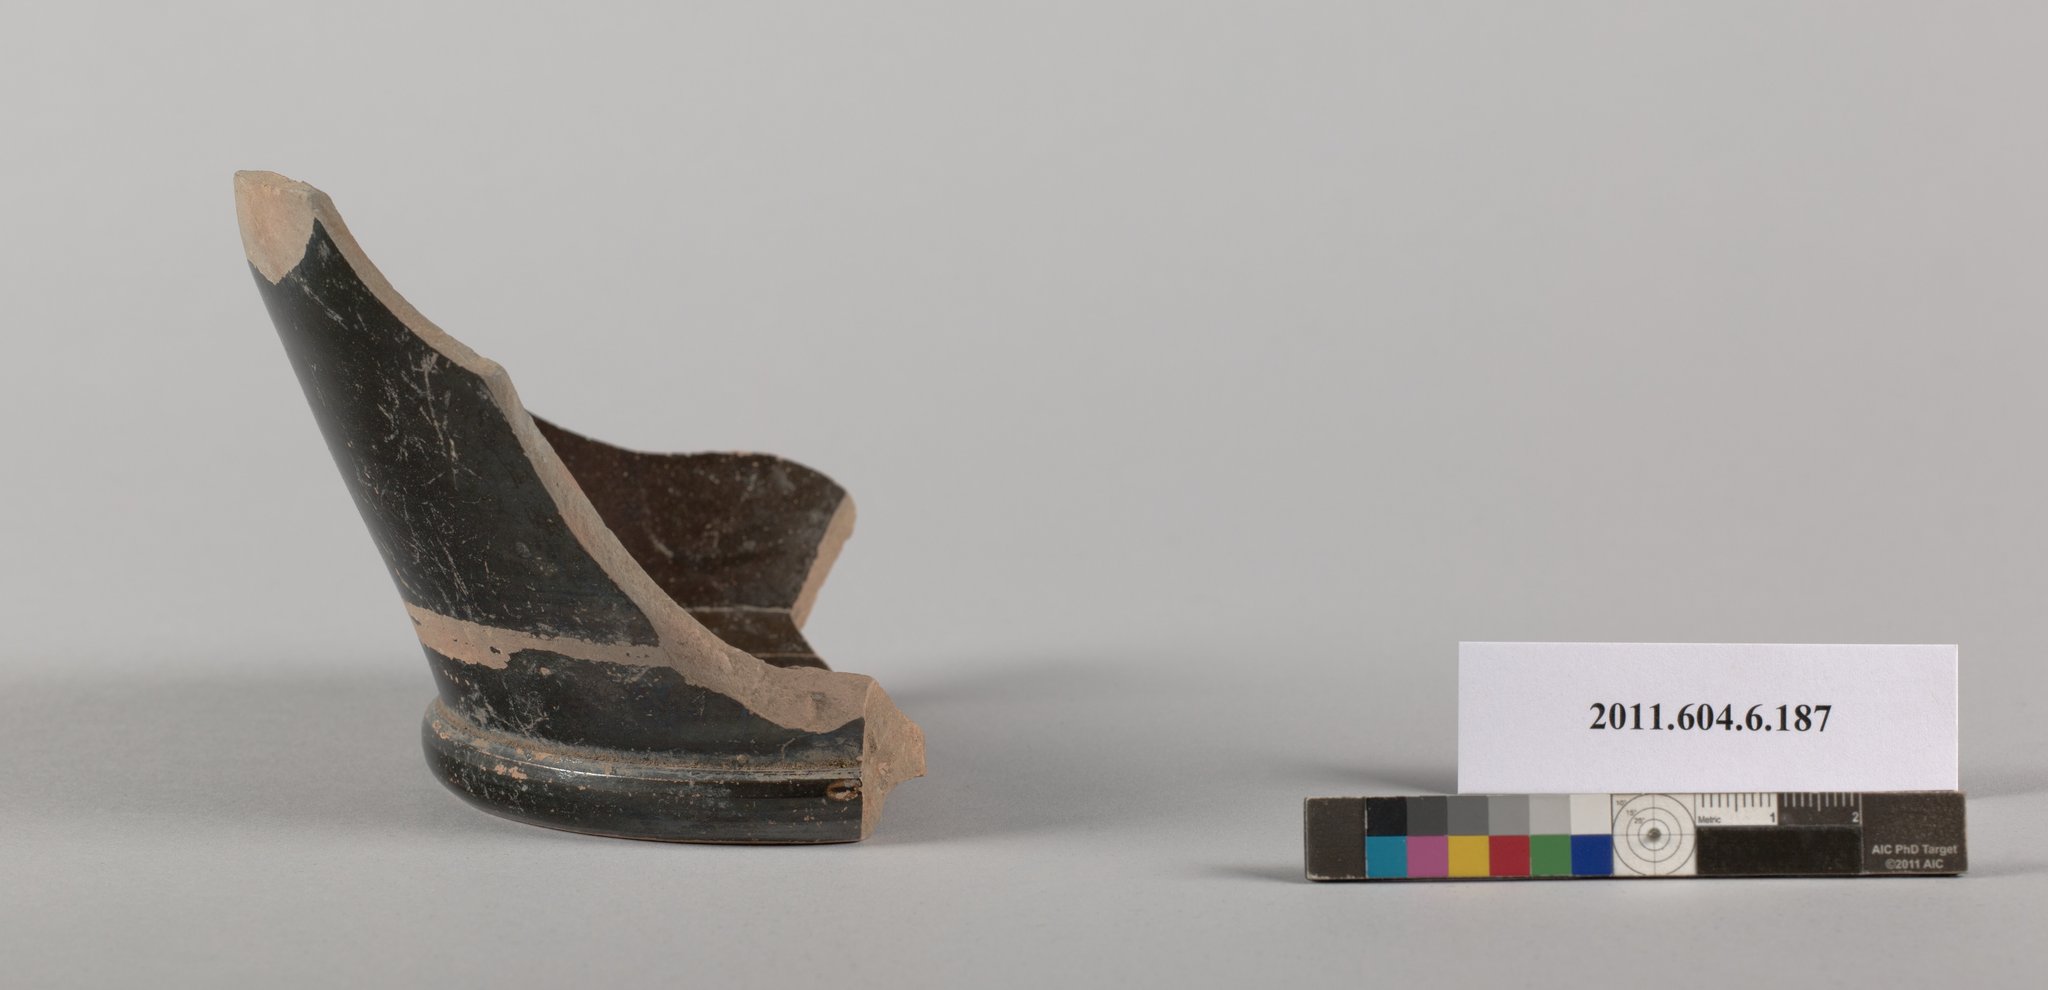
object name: skyphos fragment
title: Terracotta fragment of a skyphos (deep drinking cup)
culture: greek, attic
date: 500-401 BCE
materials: terracotta